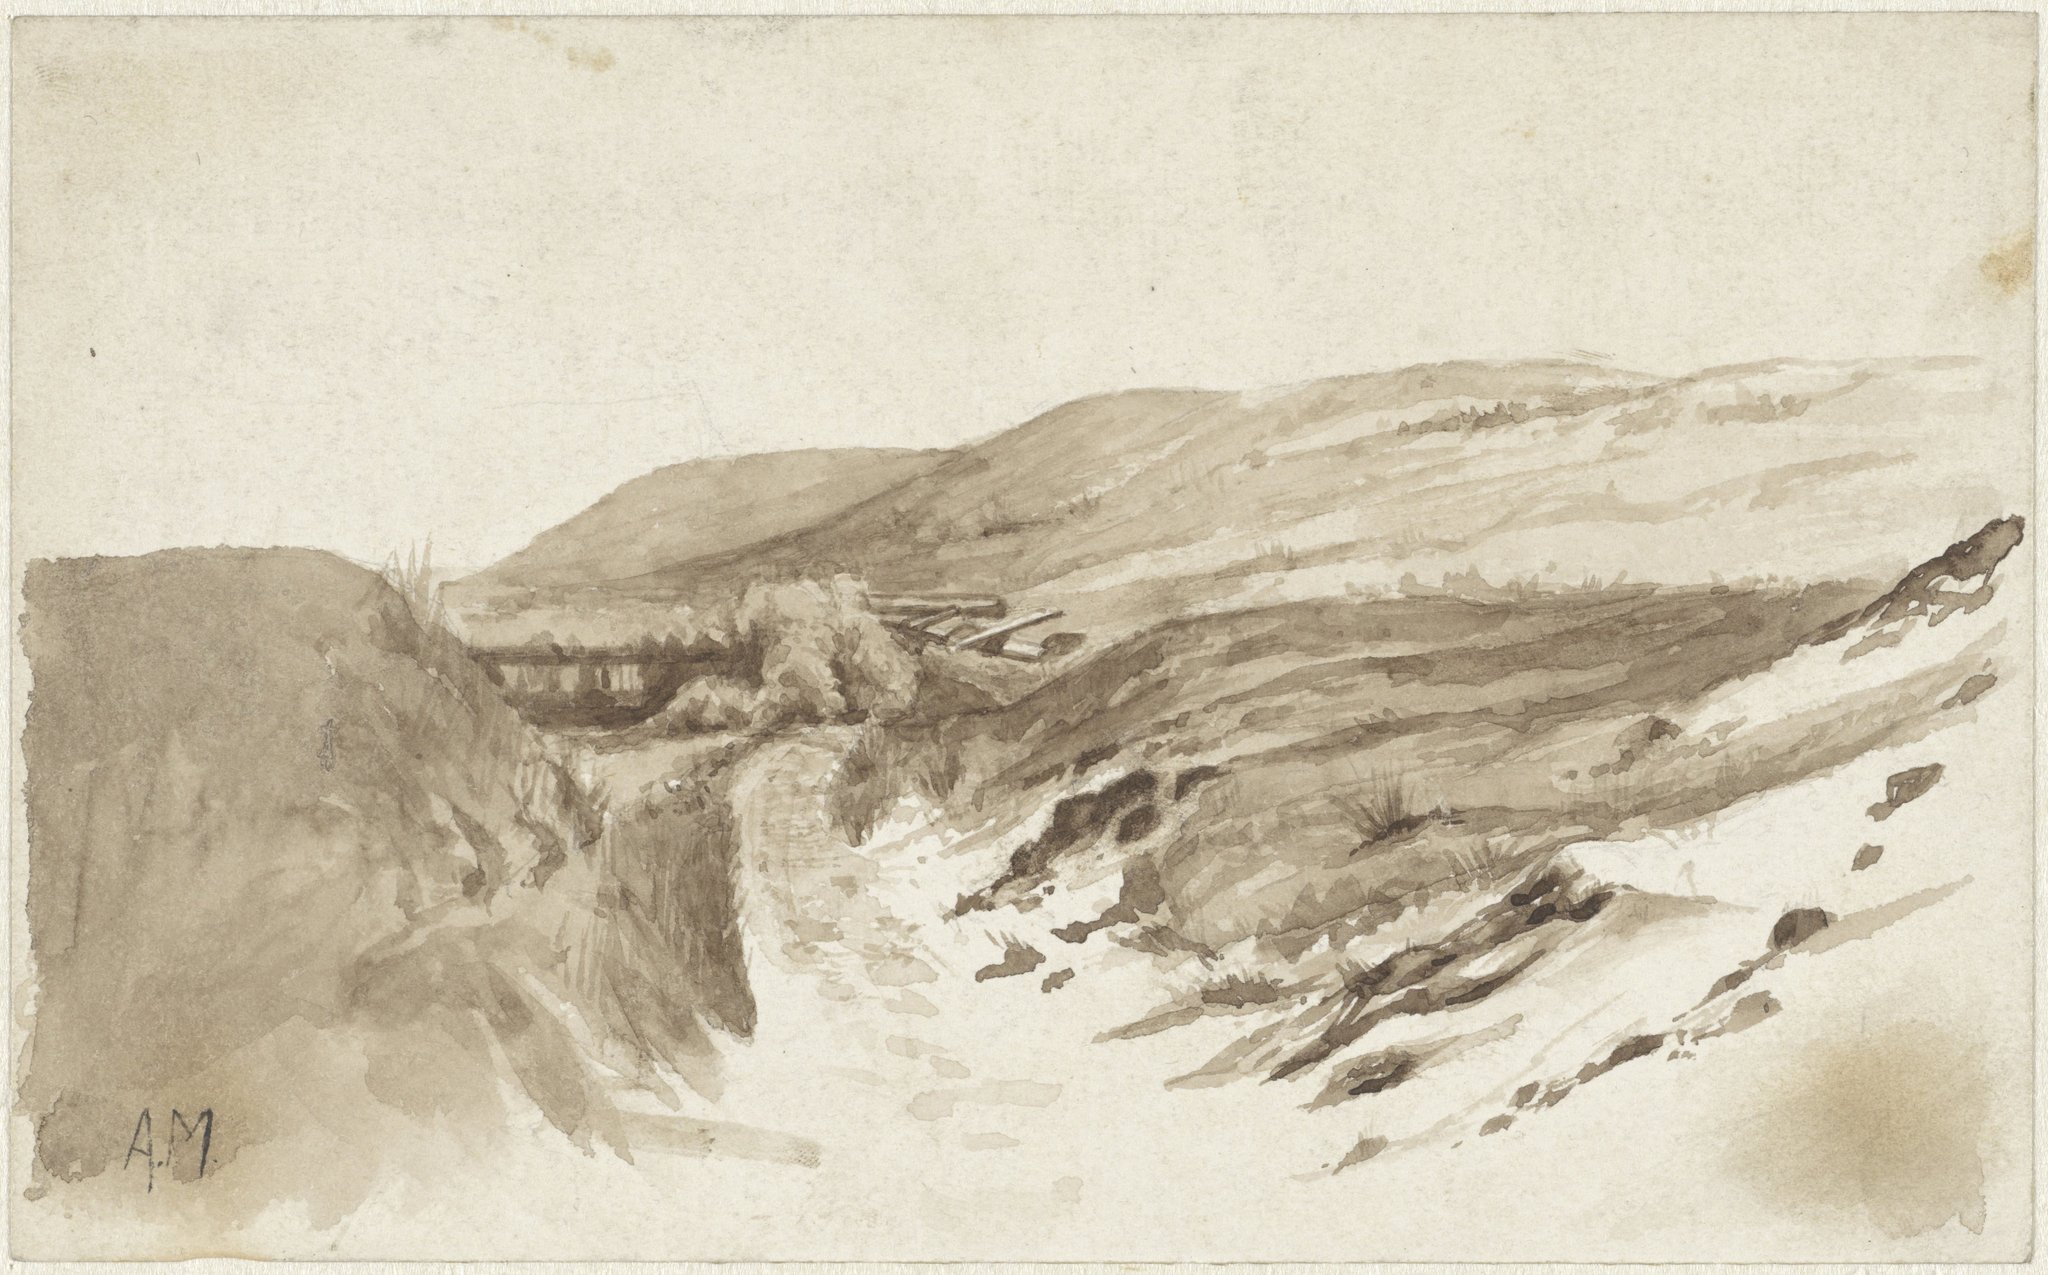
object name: drawing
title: Heuvelachtig landschap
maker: anton mauve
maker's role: draughtsman, painter, print maker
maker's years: 1838-1888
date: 1848-1888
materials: paper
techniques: brush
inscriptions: monogram: ‘A.M.’